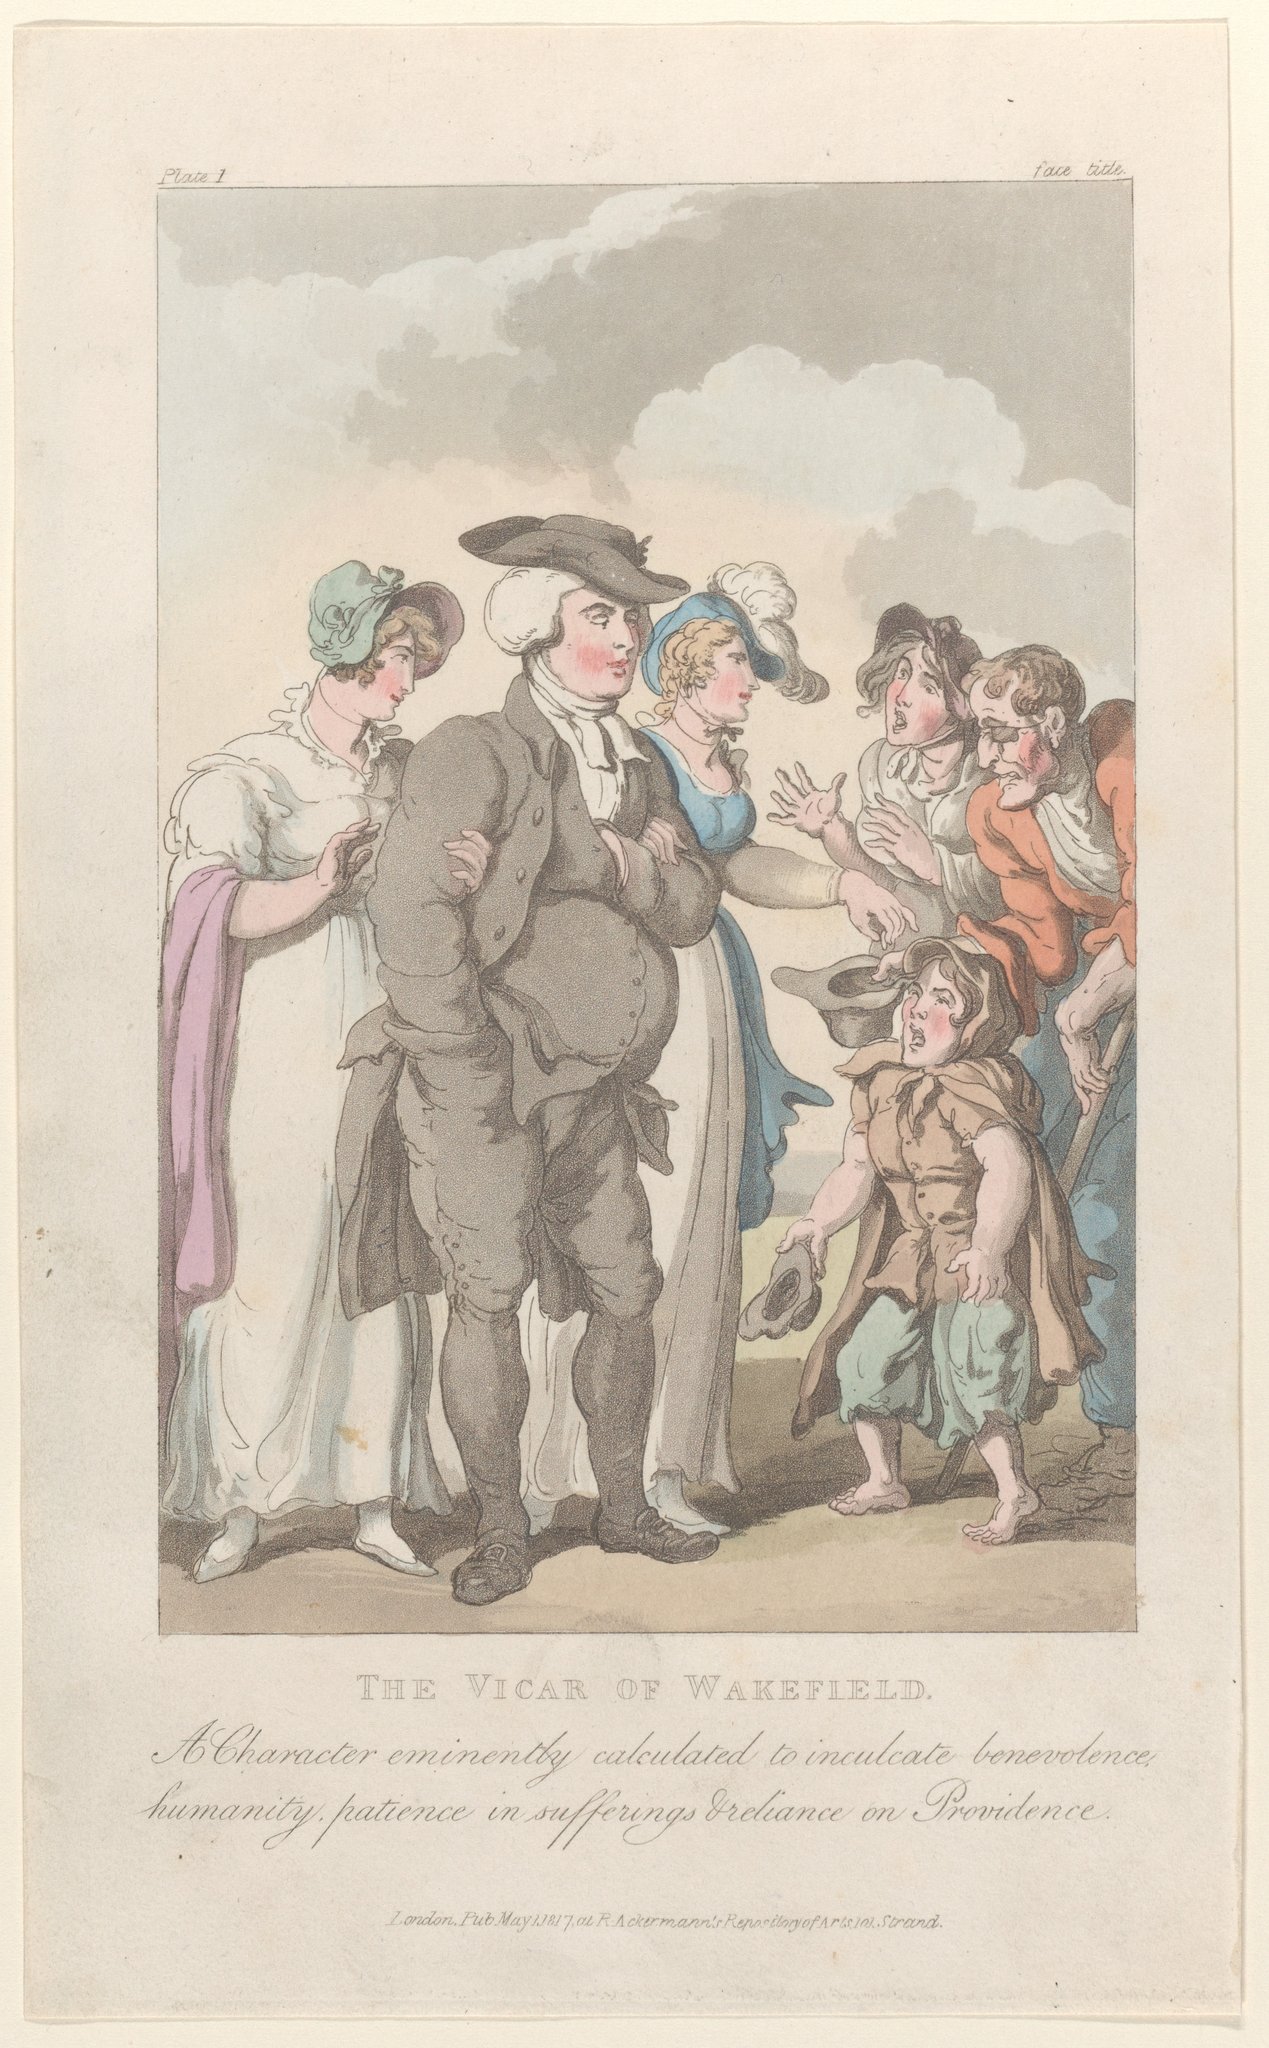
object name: print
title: Frontispiece: The Vicar of Wakefield, from "The Vicar of Wakefield"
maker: thomas rowlandson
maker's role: artist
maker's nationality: british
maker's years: 1757-1827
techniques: aquatint, etching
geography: london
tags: children,men,women